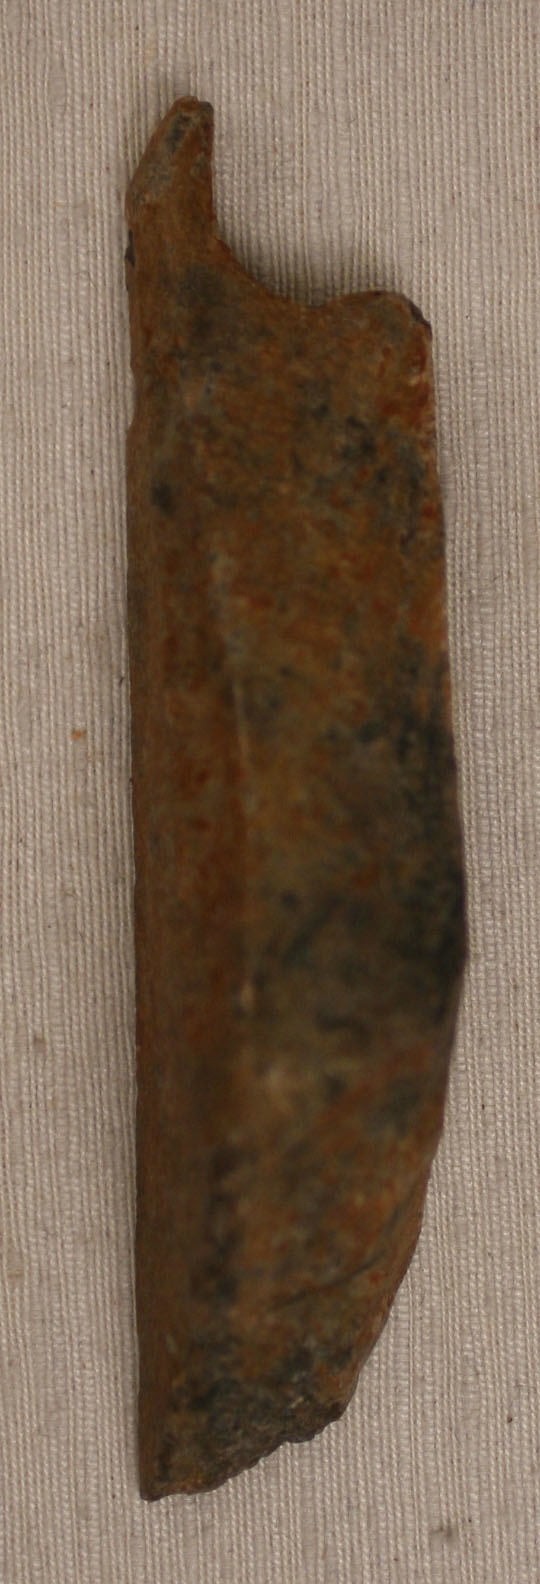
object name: glass fragment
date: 801-900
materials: glass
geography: iraq